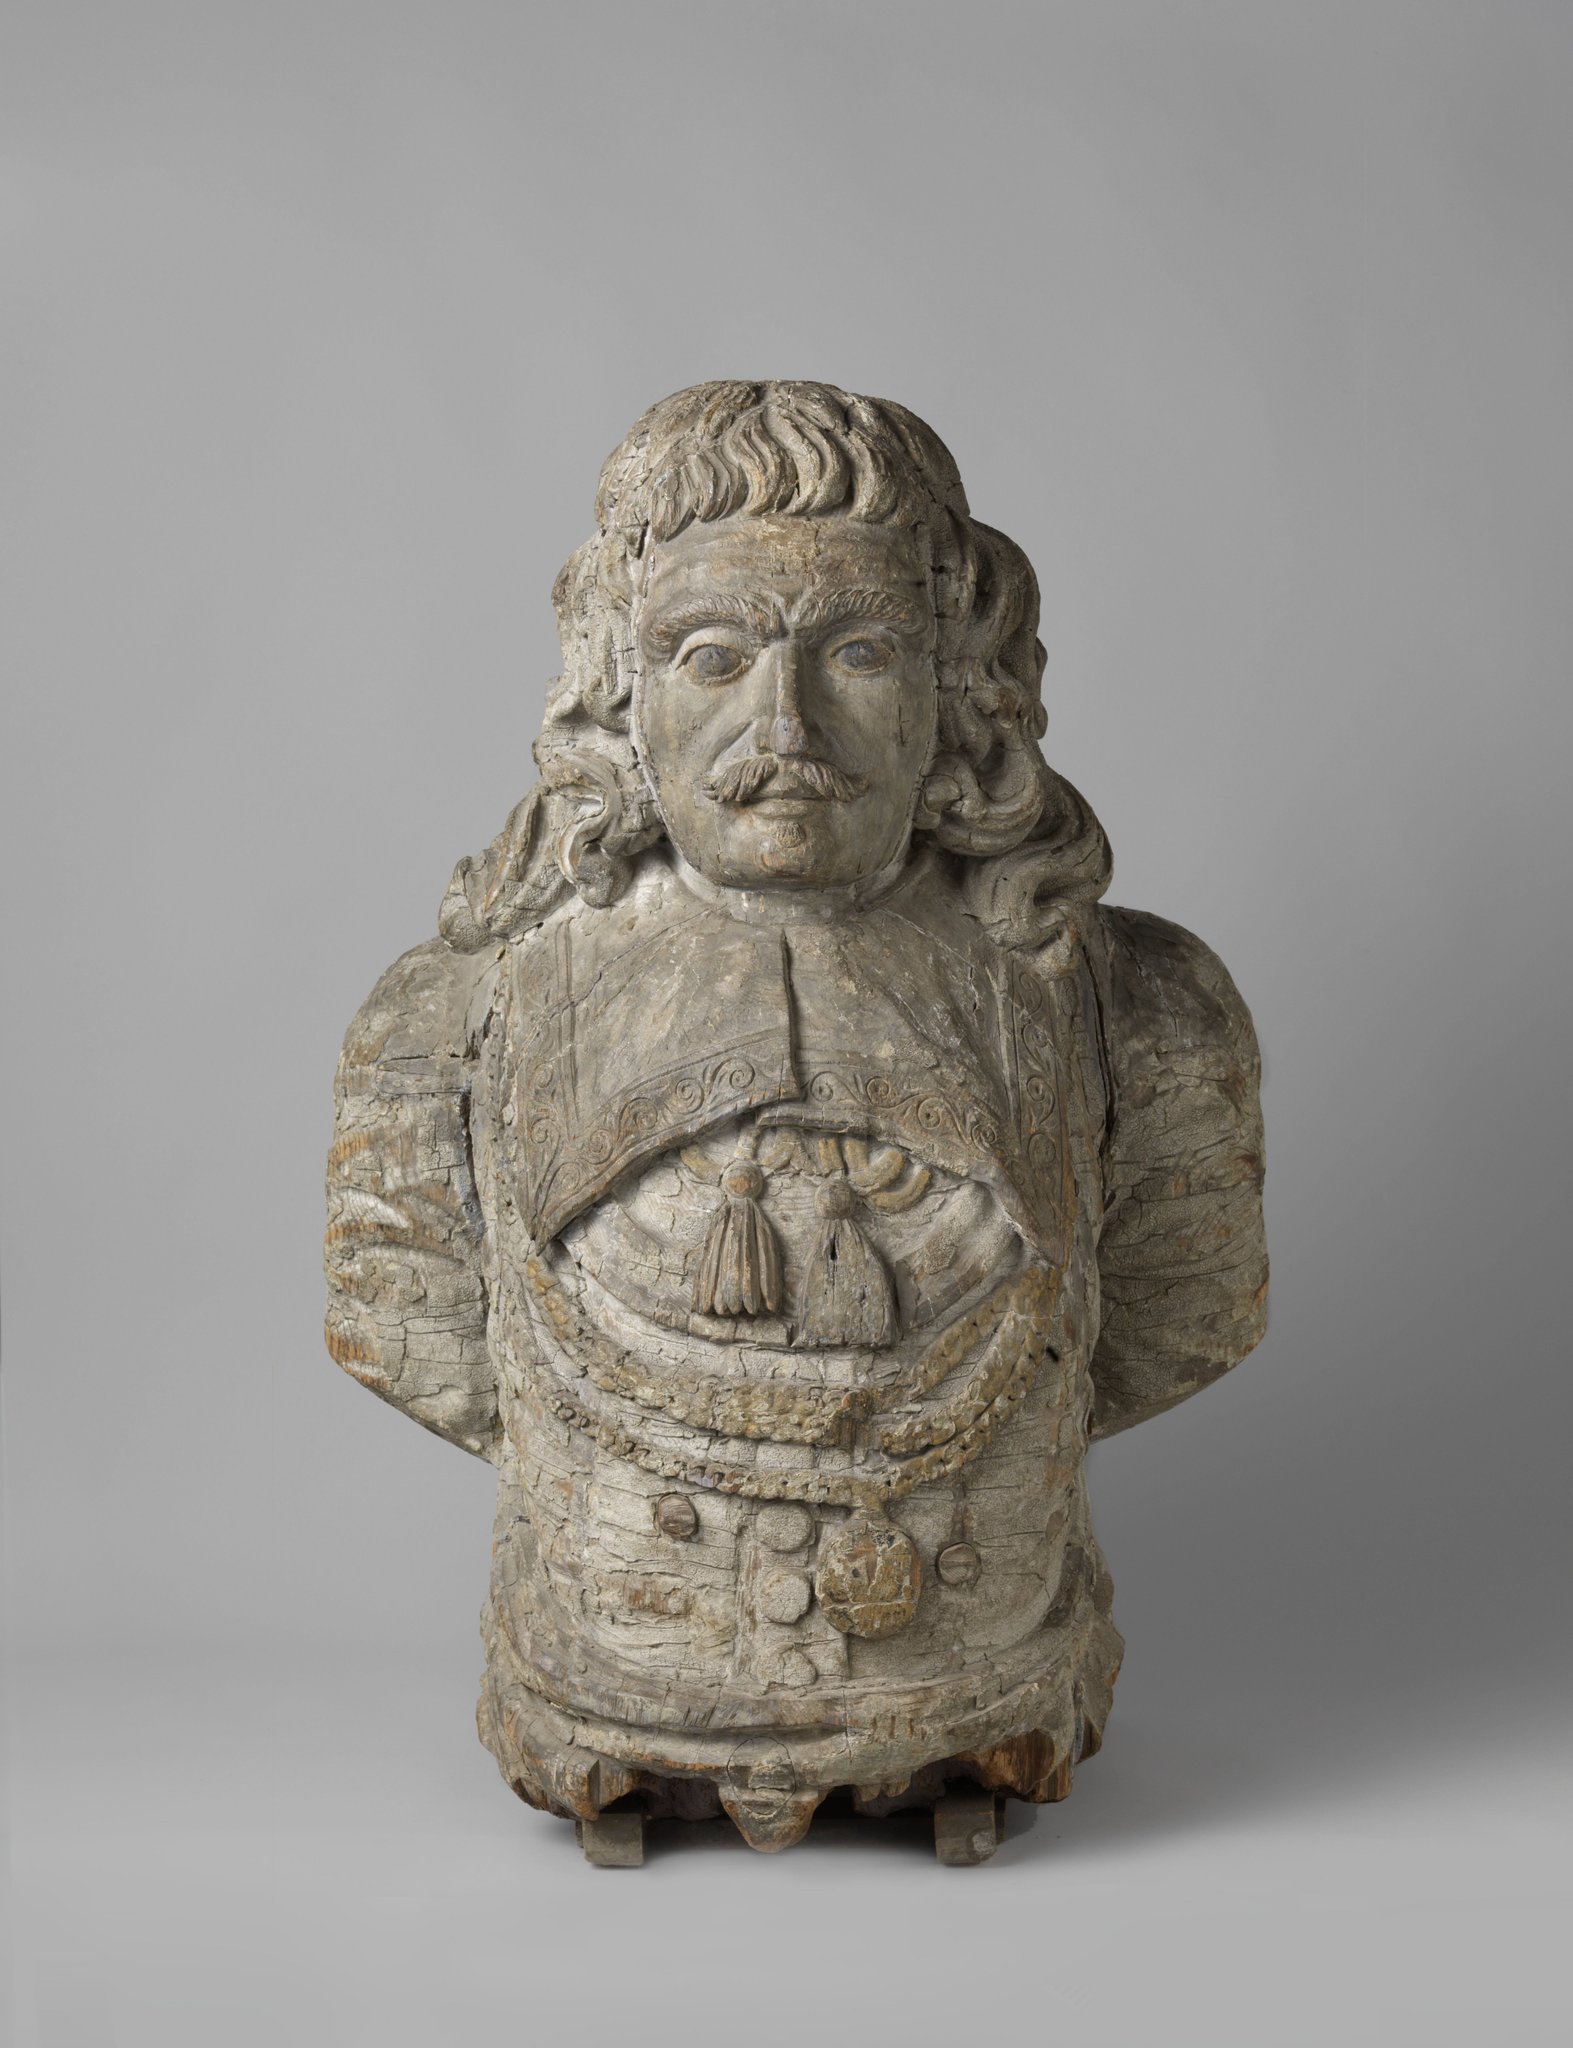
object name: figurehead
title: Schegbeeld van eikenhout van admiraal Michiel Adriaenszoon de Ruyter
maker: Anonymous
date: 1800-1850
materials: wood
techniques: gilding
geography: netherlands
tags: flushing, michiel adriaenszoon de ruyter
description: Schegbeeld van eikenhout, vermoedelijk voorstellende een borstbeeld van admiraal Michiel Adriaenszoon de Ruyter. Hij is gekleed in een jas met platte, ronde knopen en een platte kraag met twee kwastjes. Op de borst draagt hij een grote penning aan een driedubbele keten. Op de keten sporen van verguldsel.